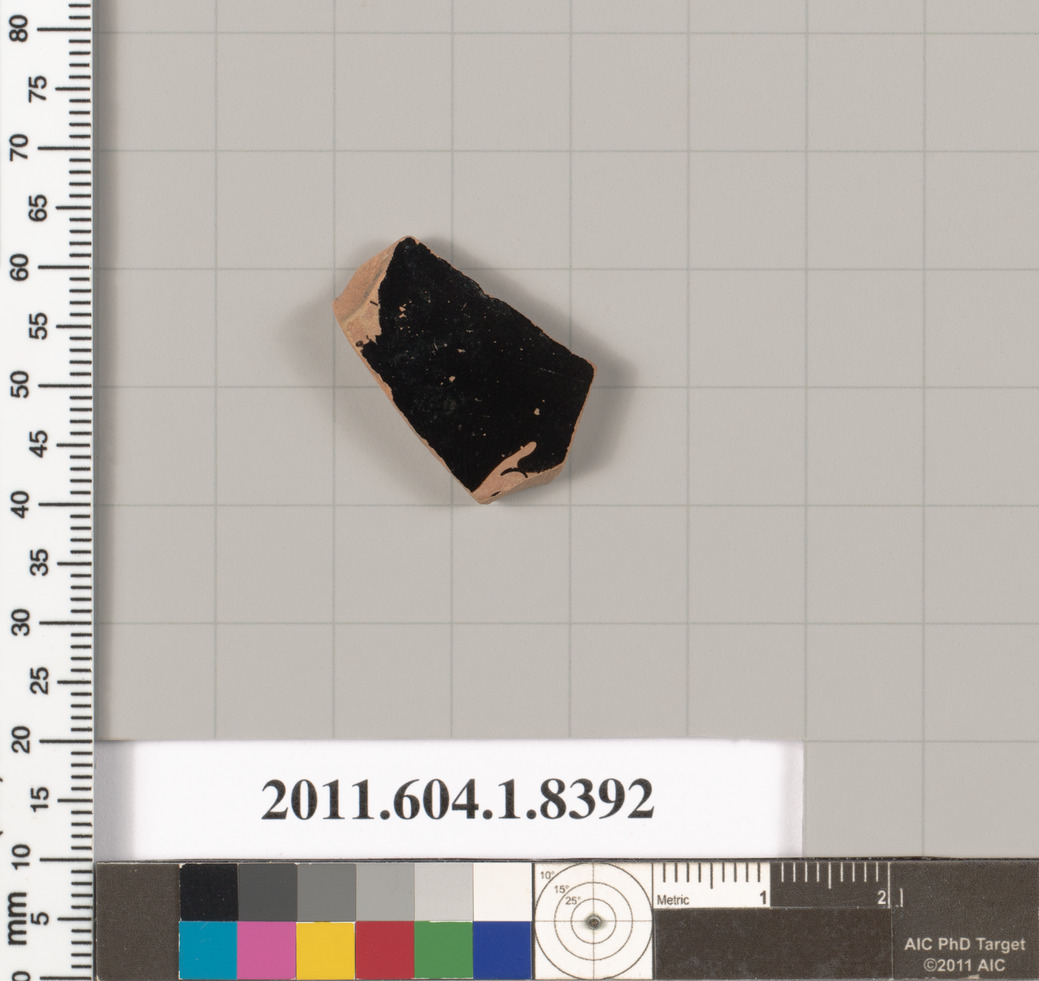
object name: kylix fragment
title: Terracotta fragment of a kylix (drinking cup)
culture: greek, attic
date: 434-401 BCE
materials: terracotta